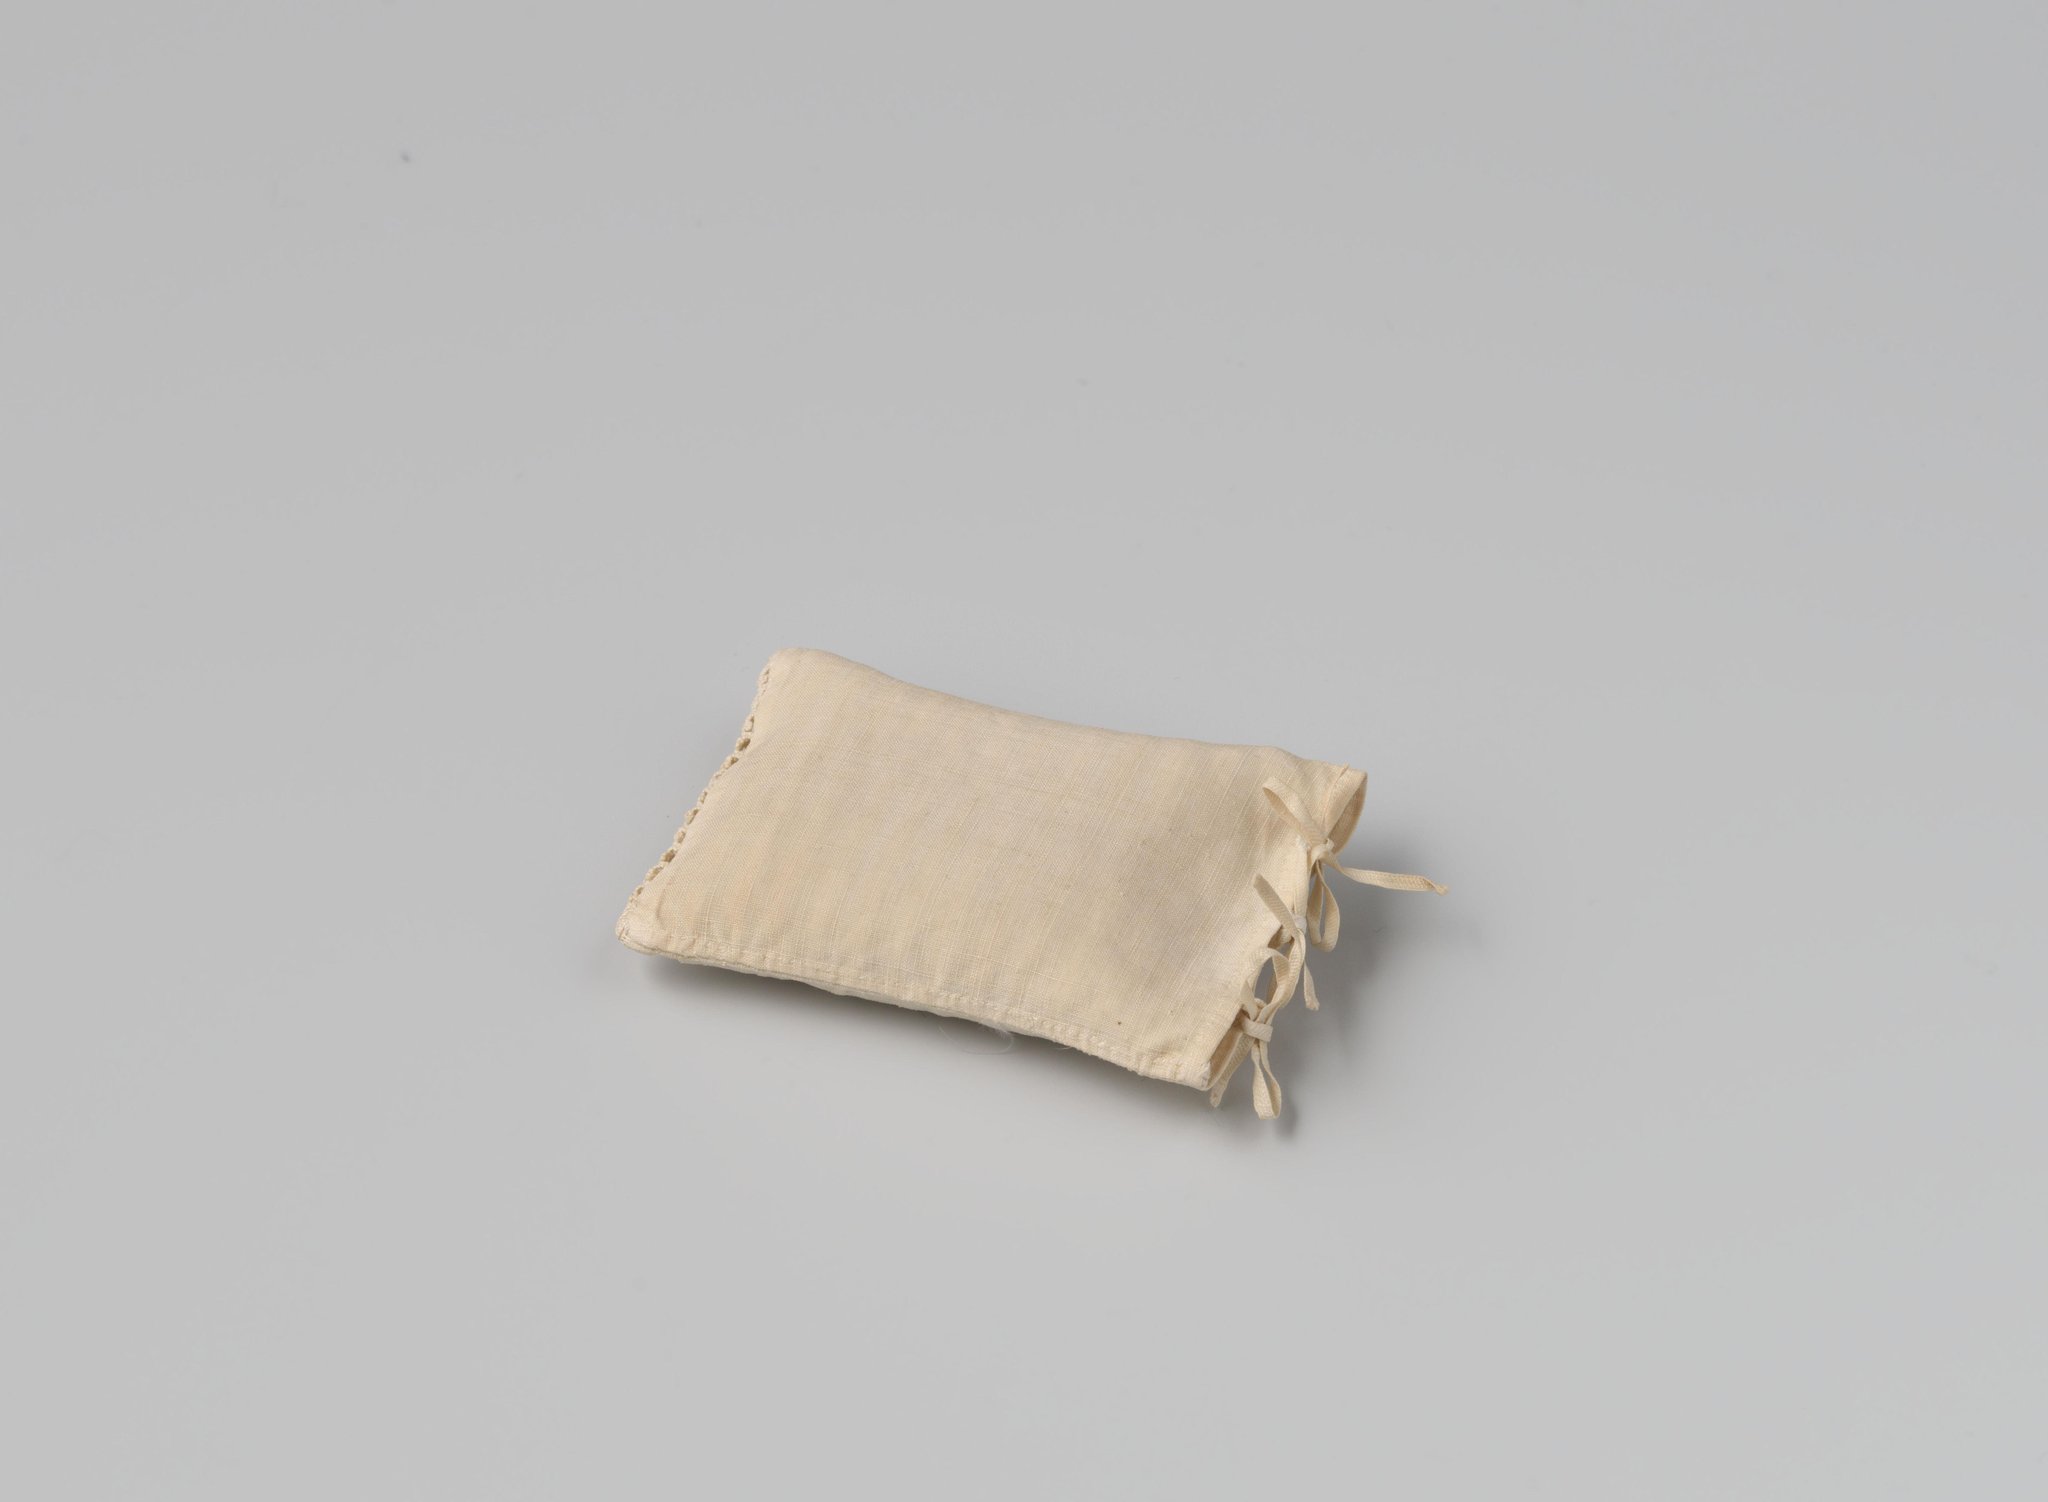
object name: miniature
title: Kussen, blauw-wit gestreept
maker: Anonymous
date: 1690-1710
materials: cotton, down, linen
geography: amsterdam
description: Kussen van blauw-wit gestreept linnen- en katoenweefsel. Het kussen is gevuld met dons.